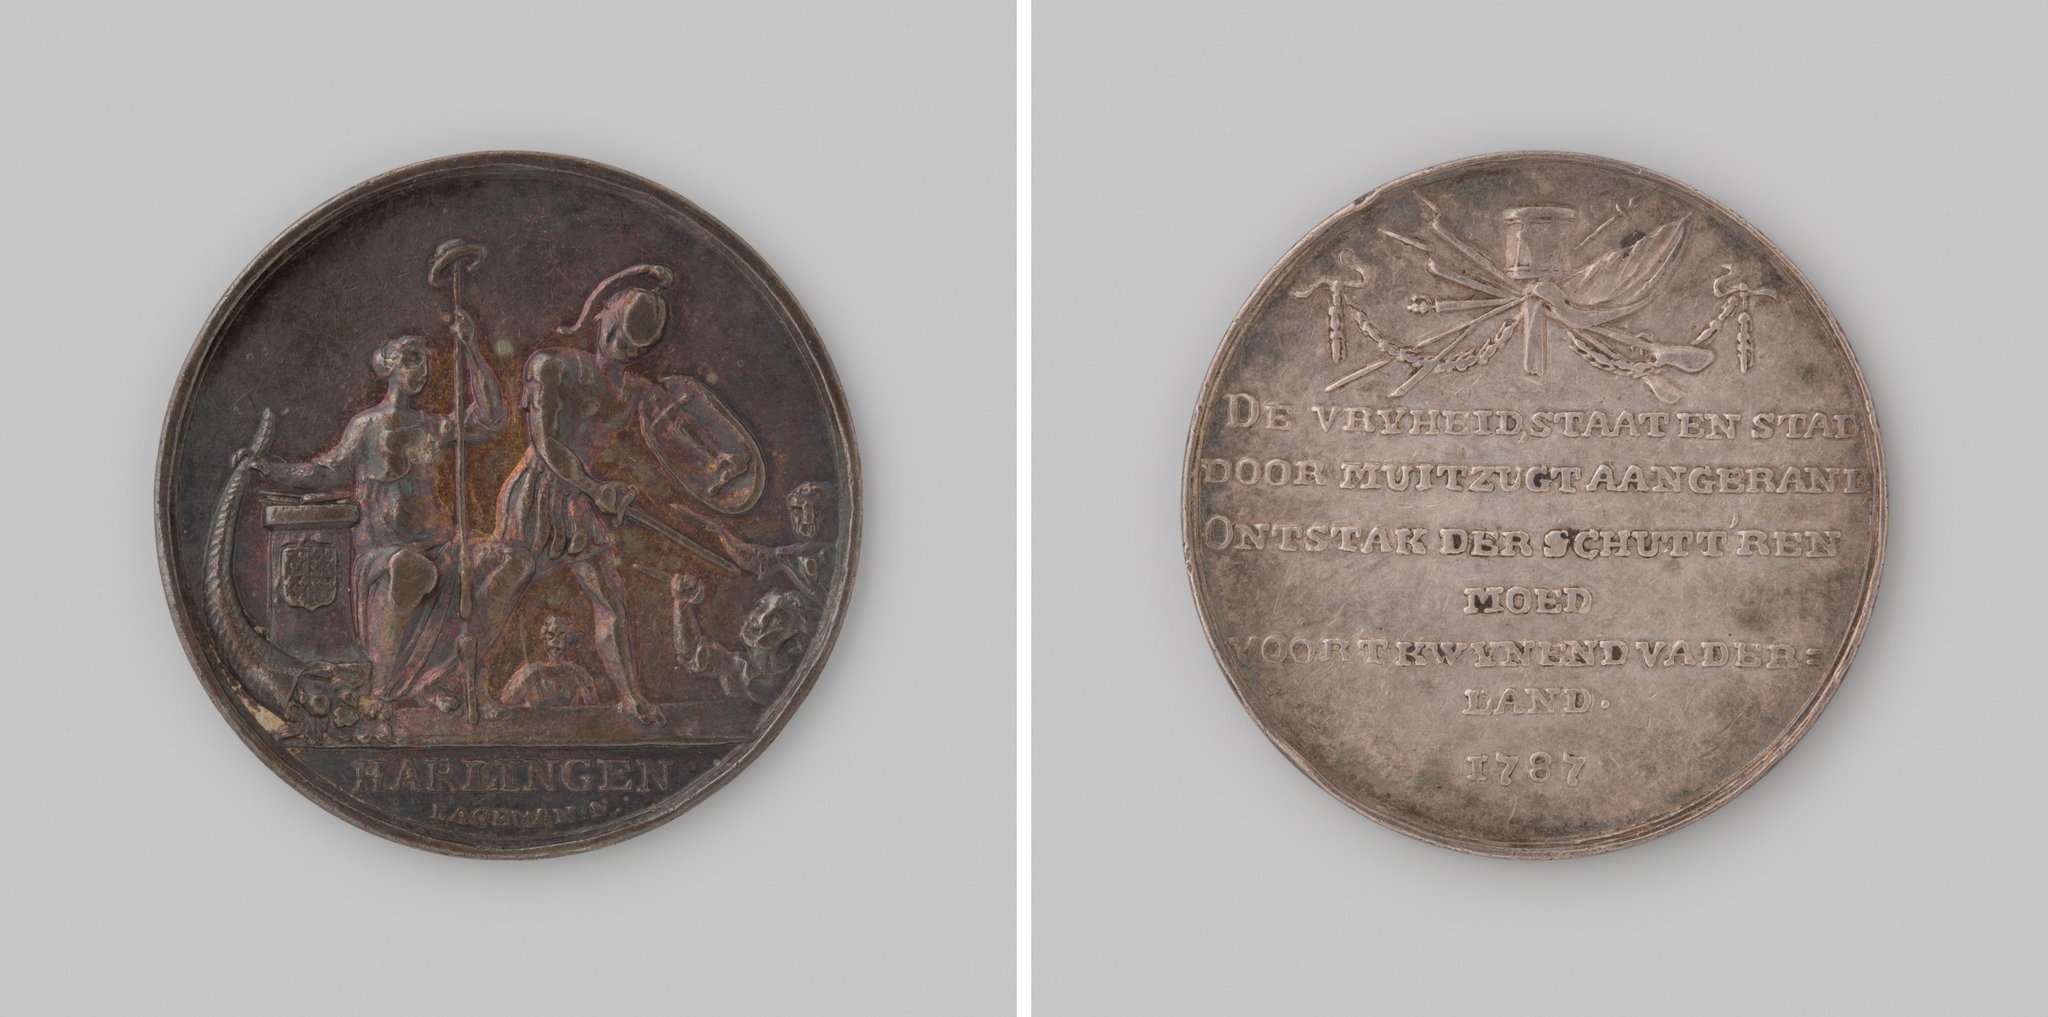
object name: history medal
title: Bedwingen van het oproer te Harlingen 1787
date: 1787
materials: silver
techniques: pressing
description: Zilveren penning, op de voorzijde een antieke krijger in gevecht met drie tegenstanders, achter hem de ongehelmde Nederlandse Maagd zittend met piek met vrijheidshoed en hoorn des overvloeds, leunend op een altaar met bijbel waartegen het wapenschild van Harlingen, met afsnedetekst, op de keerzijde zeven regels tekst onder een met guirlanden behangen krijgstrofee.